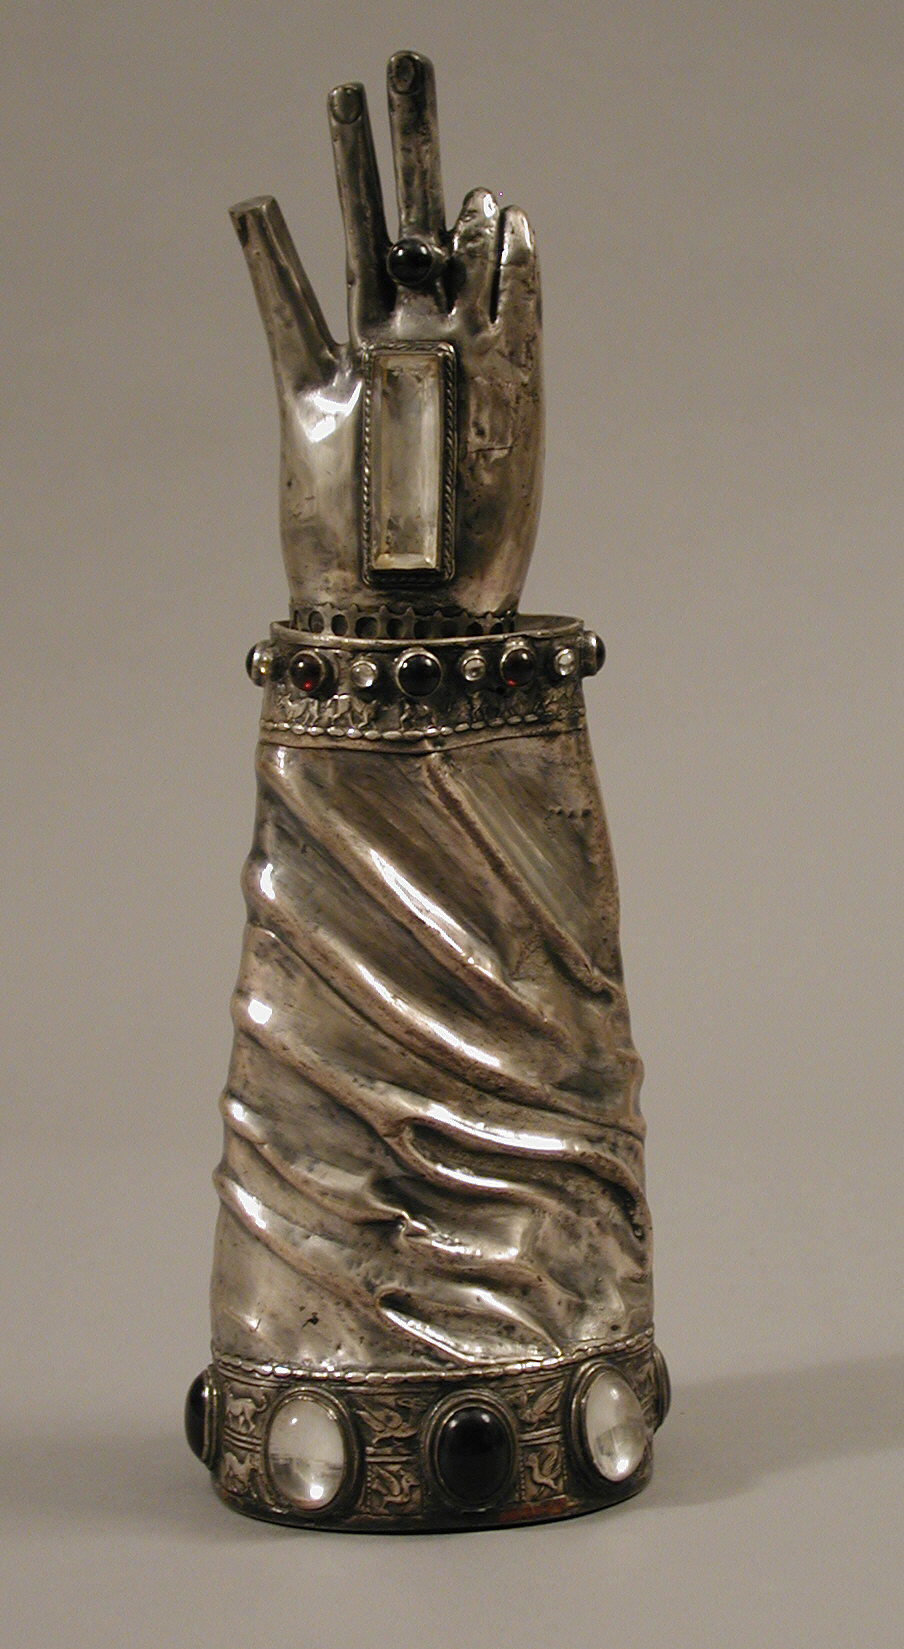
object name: shrine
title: Shrine of Saint Patrick's Hand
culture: irish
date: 1901-1933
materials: silver, stone